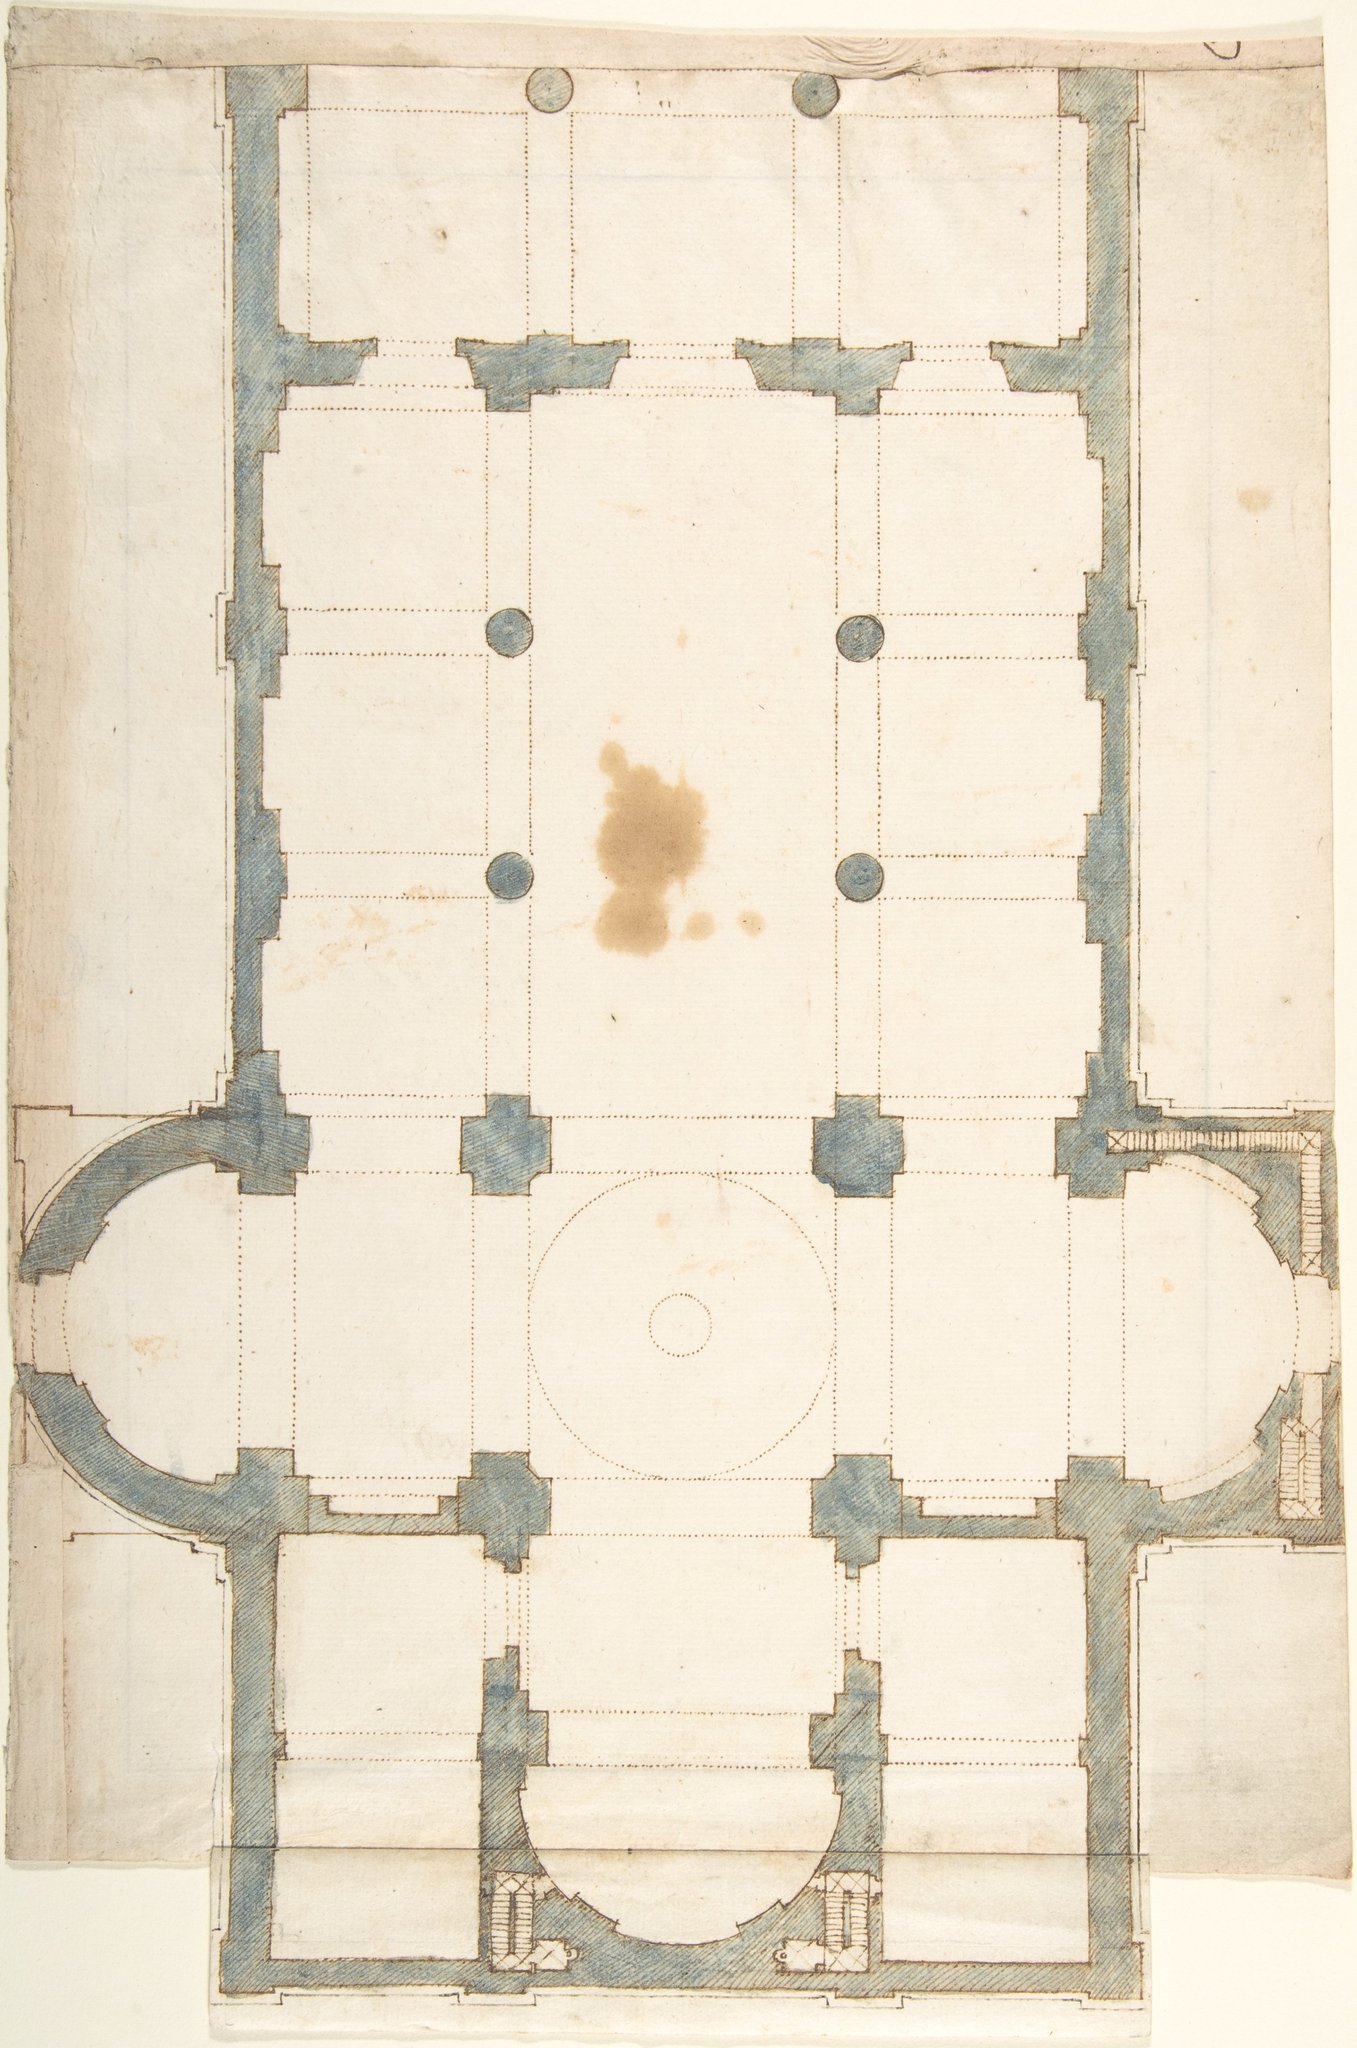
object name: drawing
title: Plan for a Church with a Nave (recto); Framing Outlines (verso)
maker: anonymous, italian, 16th century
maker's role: artist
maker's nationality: italian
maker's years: 1550-1600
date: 1501-1600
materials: ink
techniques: brush, incising, pen, wash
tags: architecture,churches